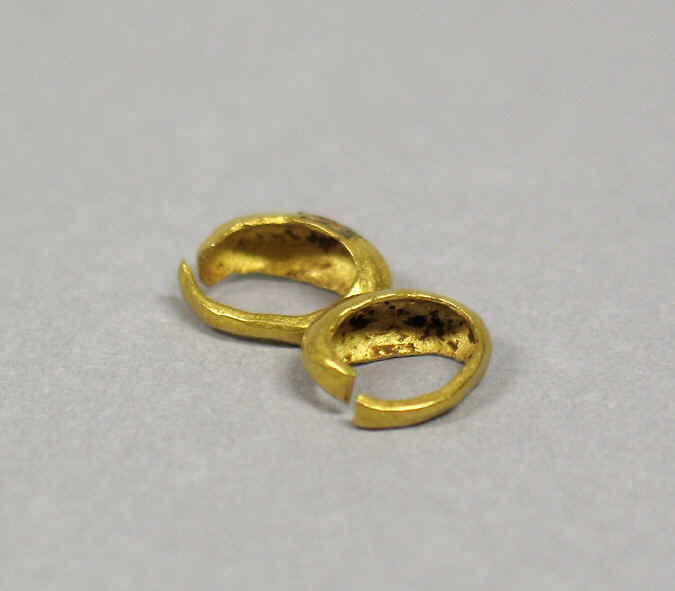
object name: pair of earring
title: Pair of Earrings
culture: indonesian, central java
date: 701-1200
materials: gold